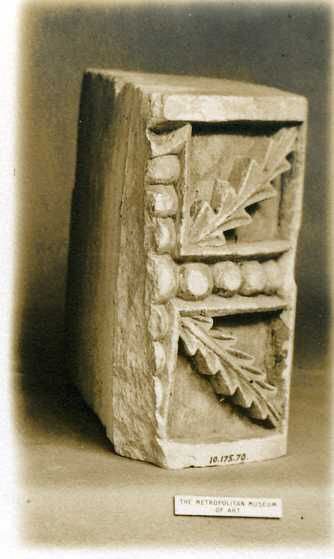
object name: fragment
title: Fragment of a Block with a Beaded Cross and Leaves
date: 501-700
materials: limestone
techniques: carving, relief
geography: egypt